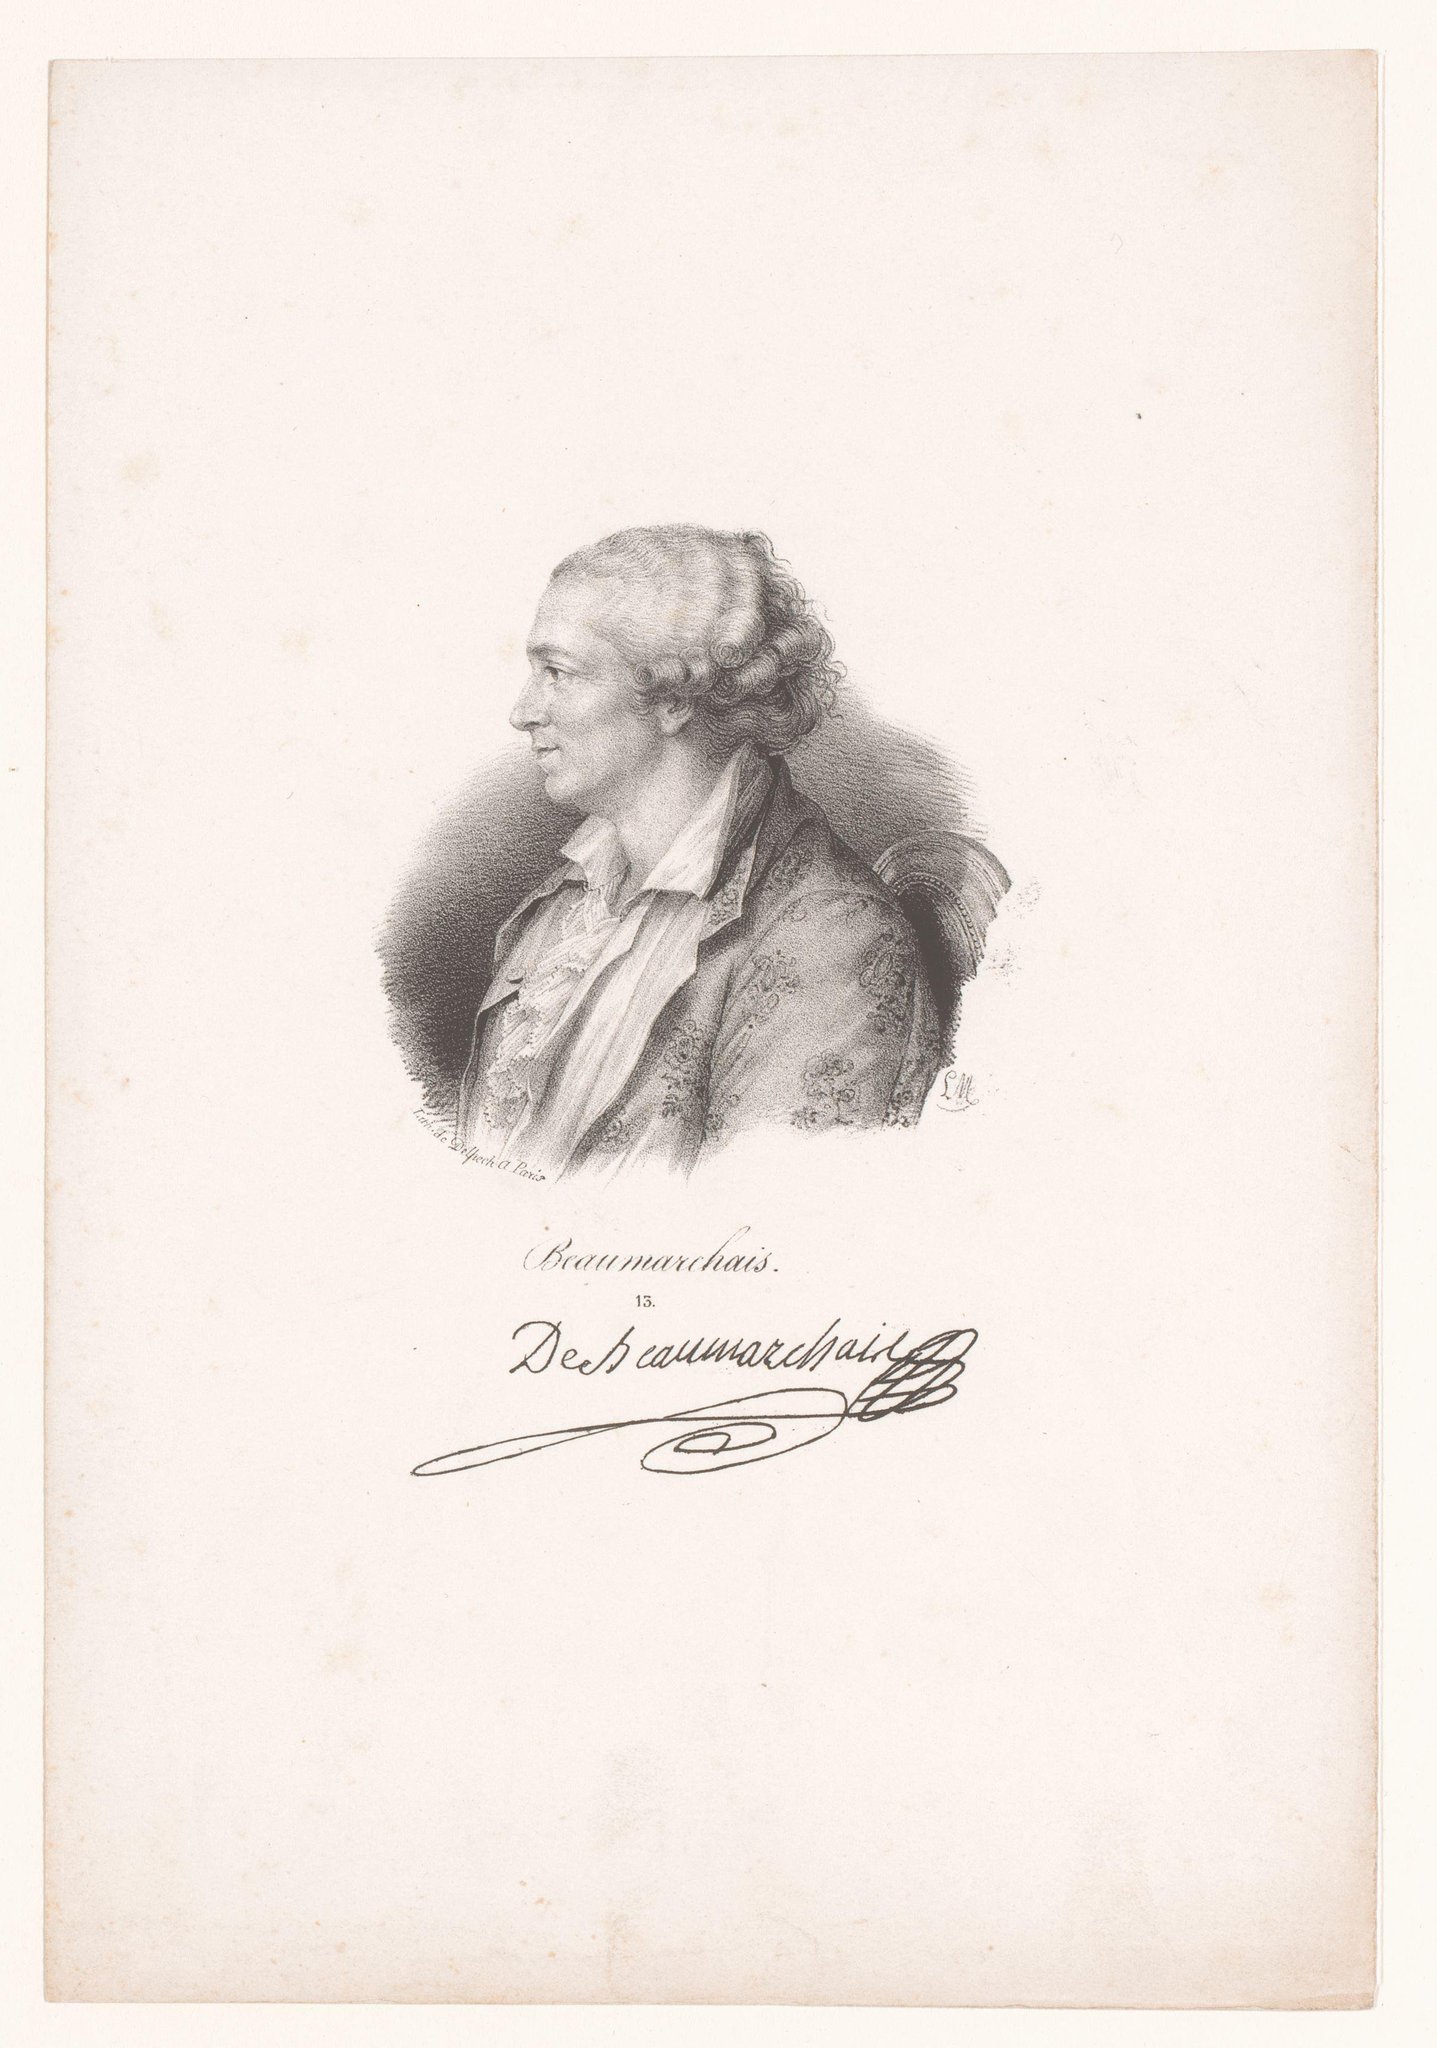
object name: print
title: Beaumarchais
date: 1825-1842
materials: paper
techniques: lithograph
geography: paris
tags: paris, publisher, historical persons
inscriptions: collector's mark: Lugt 2228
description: Prent waarschijnlijk gebruikt voor: Iconographie des contemporains ou Portraits des personnes dont les noms se rattachent plus particulièrement, soit par leurs actions, soit par leurs écrits, aux divers événements qui ont eu lieu en France, depuis 1789, jusqu'en 1829 (…). Parijs: veuve Delpech, 1832-1833. Mogelijk komt de prent ook voor in eerdere en/of latere publicaties uitgegeven door veuve Delpech of haar opvolger Rosselin.